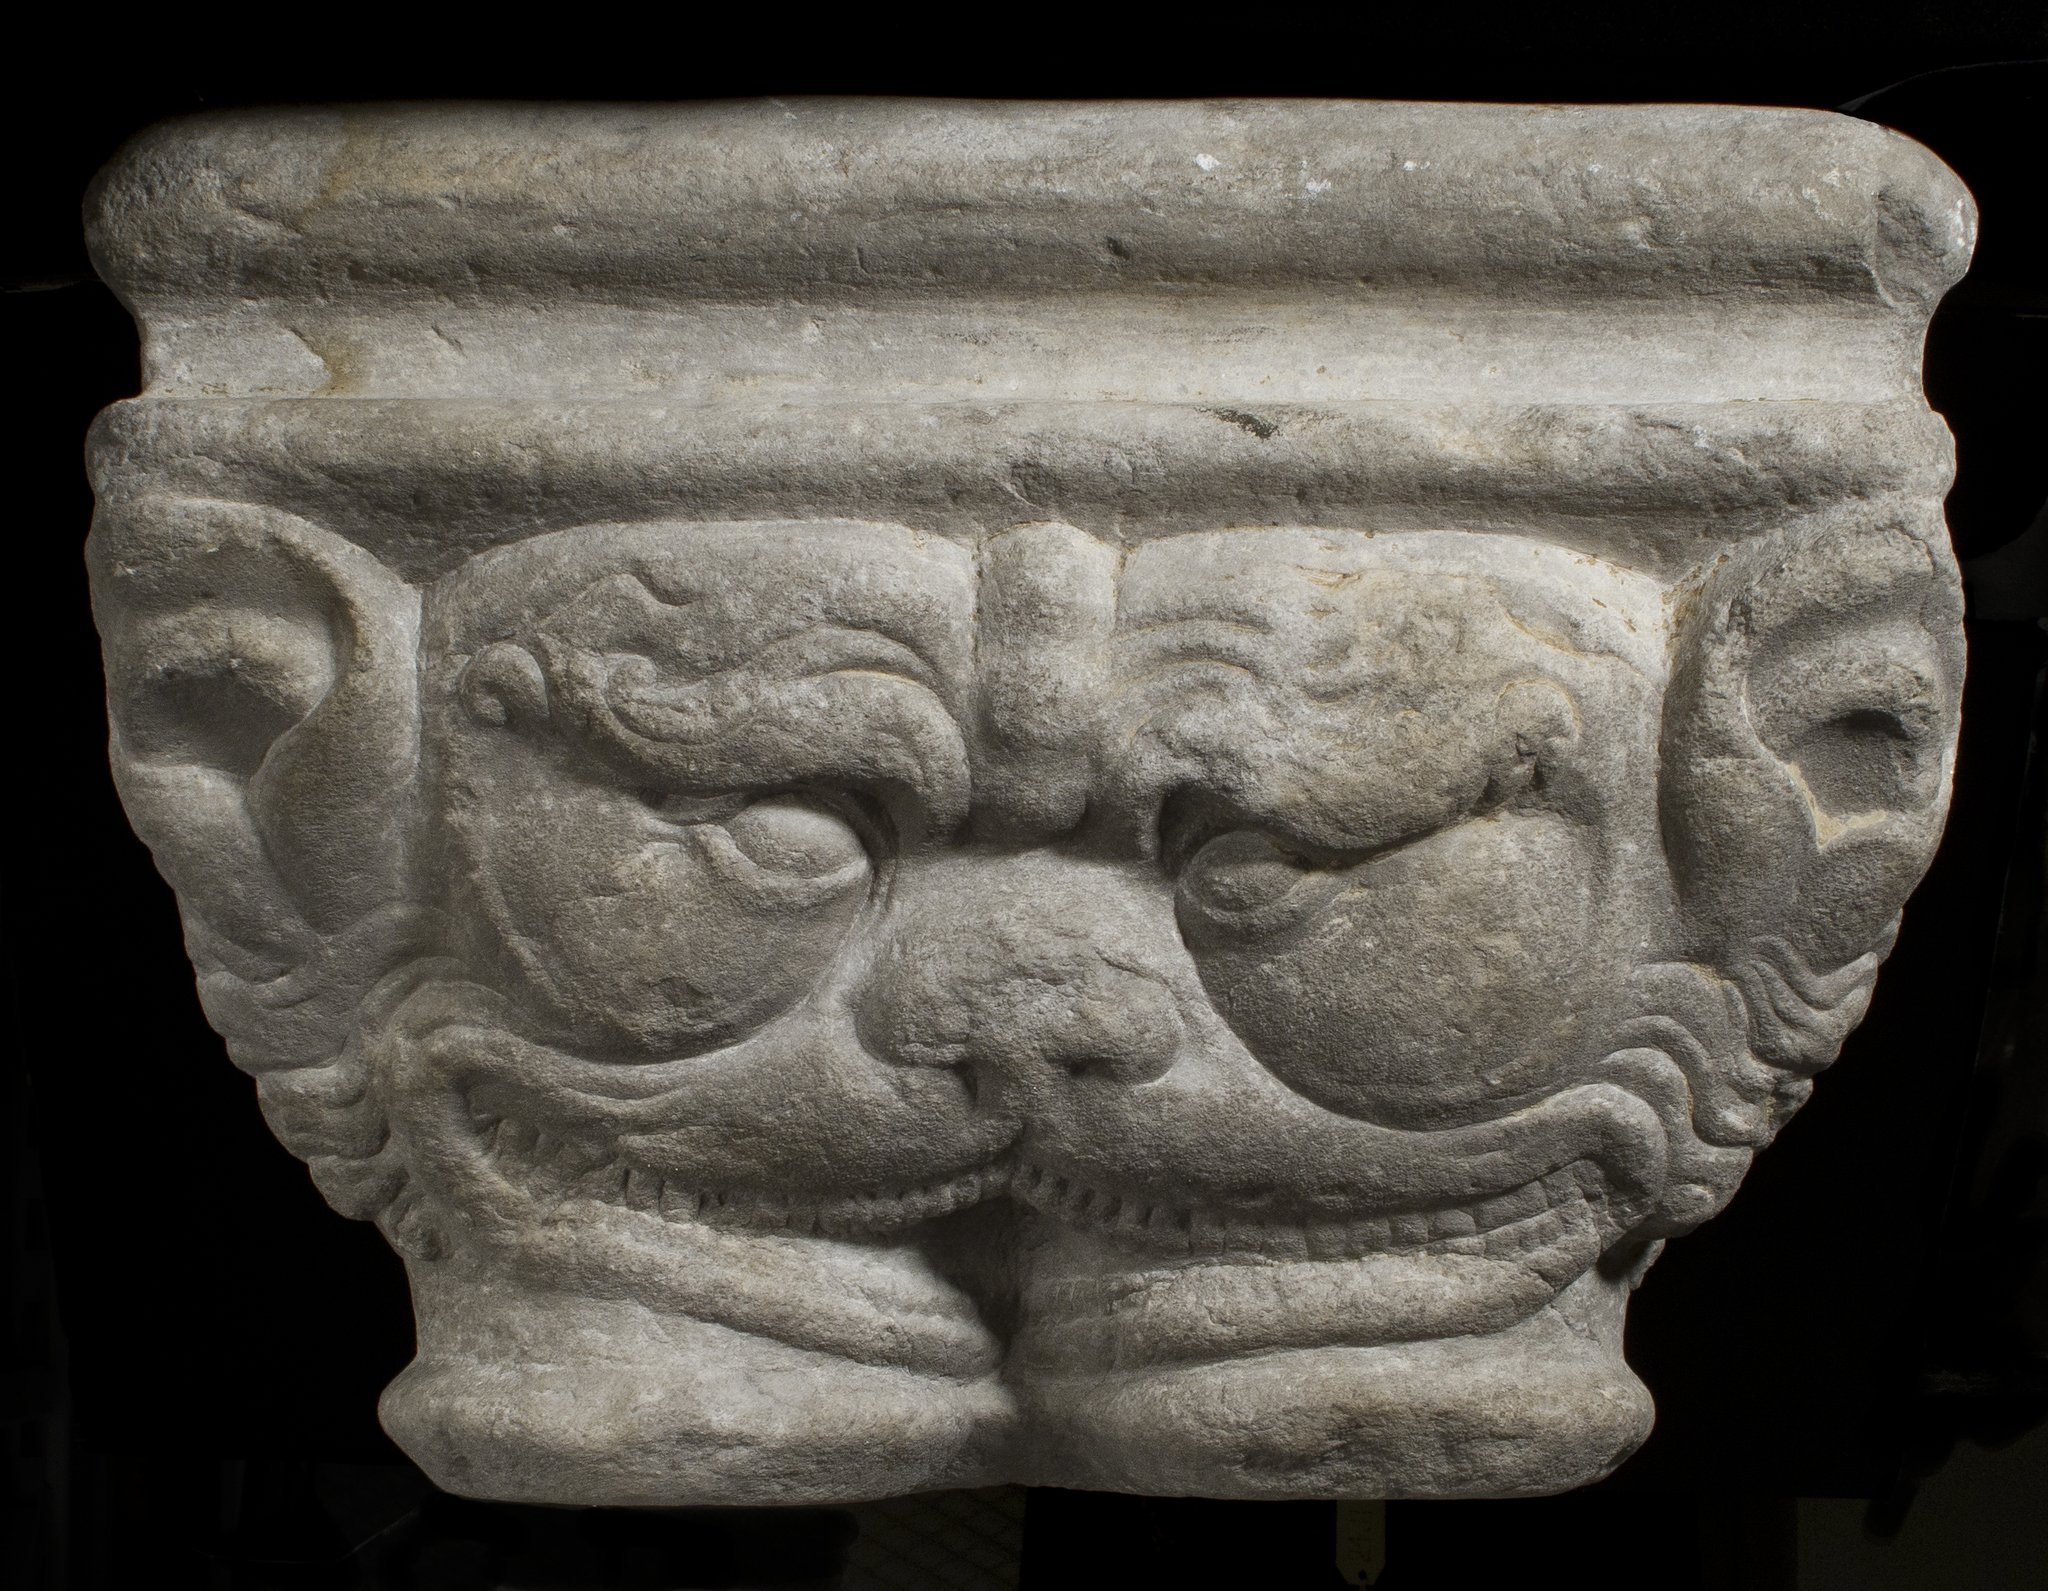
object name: capital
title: Double Capital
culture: french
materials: marble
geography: france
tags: animals